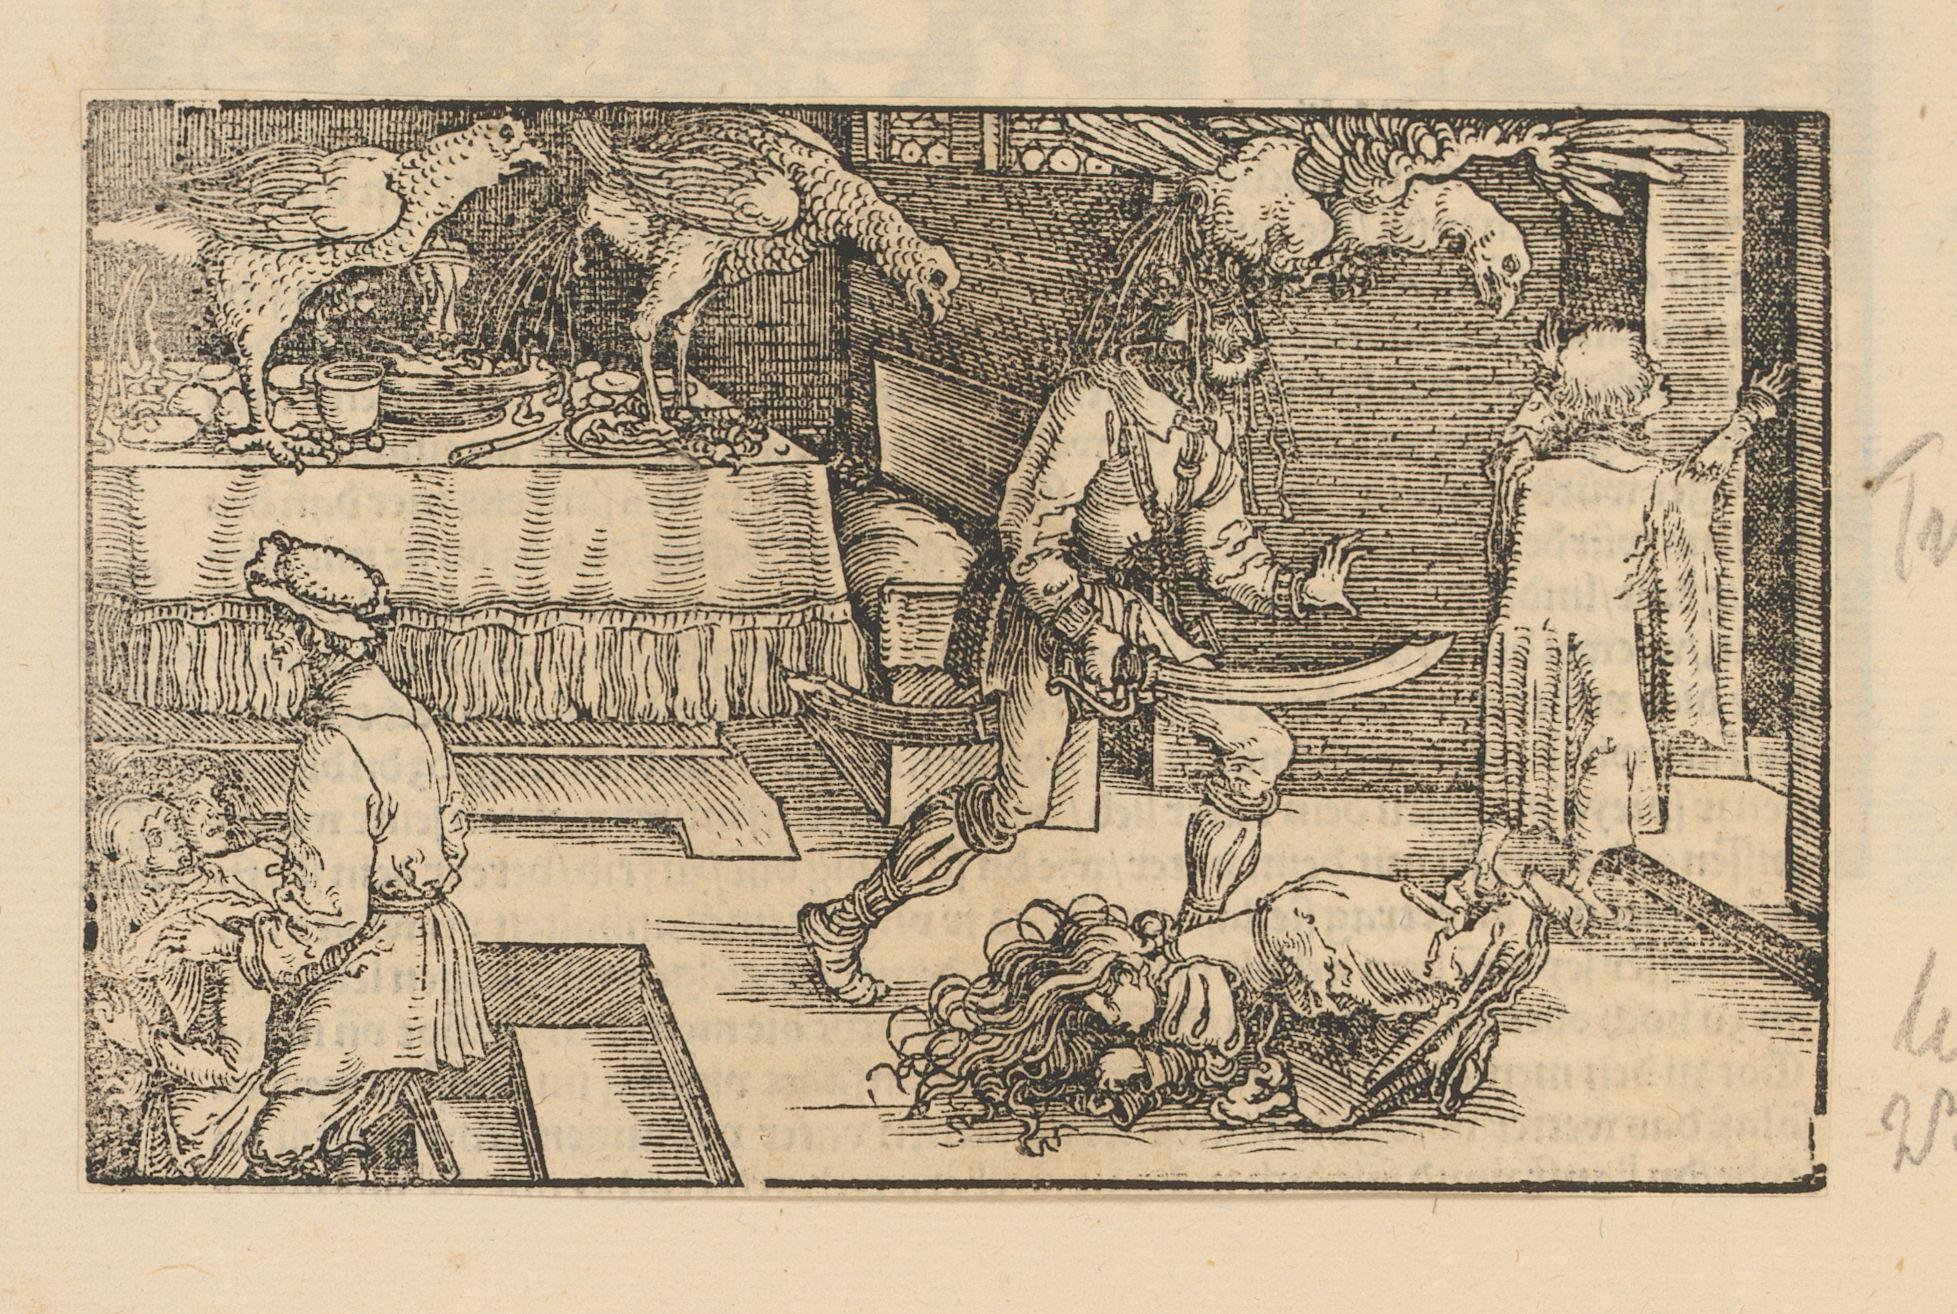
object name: book illustration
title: Vogels poepen op de huisraad en op een man die een meisje heeft doorklieft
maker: Anonymous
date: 1514-1532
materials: paper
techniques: letterpress printing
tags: birds (+ animal(s) attacking), defecation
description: Deze prent is gebruikt in: Petrarca, Francesco. Von der Artzney bayder Glück, des guten und widerwertigen: unnd weß sich ain yeder inn Gelück und Unglück halten sol (...). Augsburg: Heinrich Steiner, 1532. Deze uitgave is ook bekend onder de titel 'Trostspiegel in Glück und Unglück'.